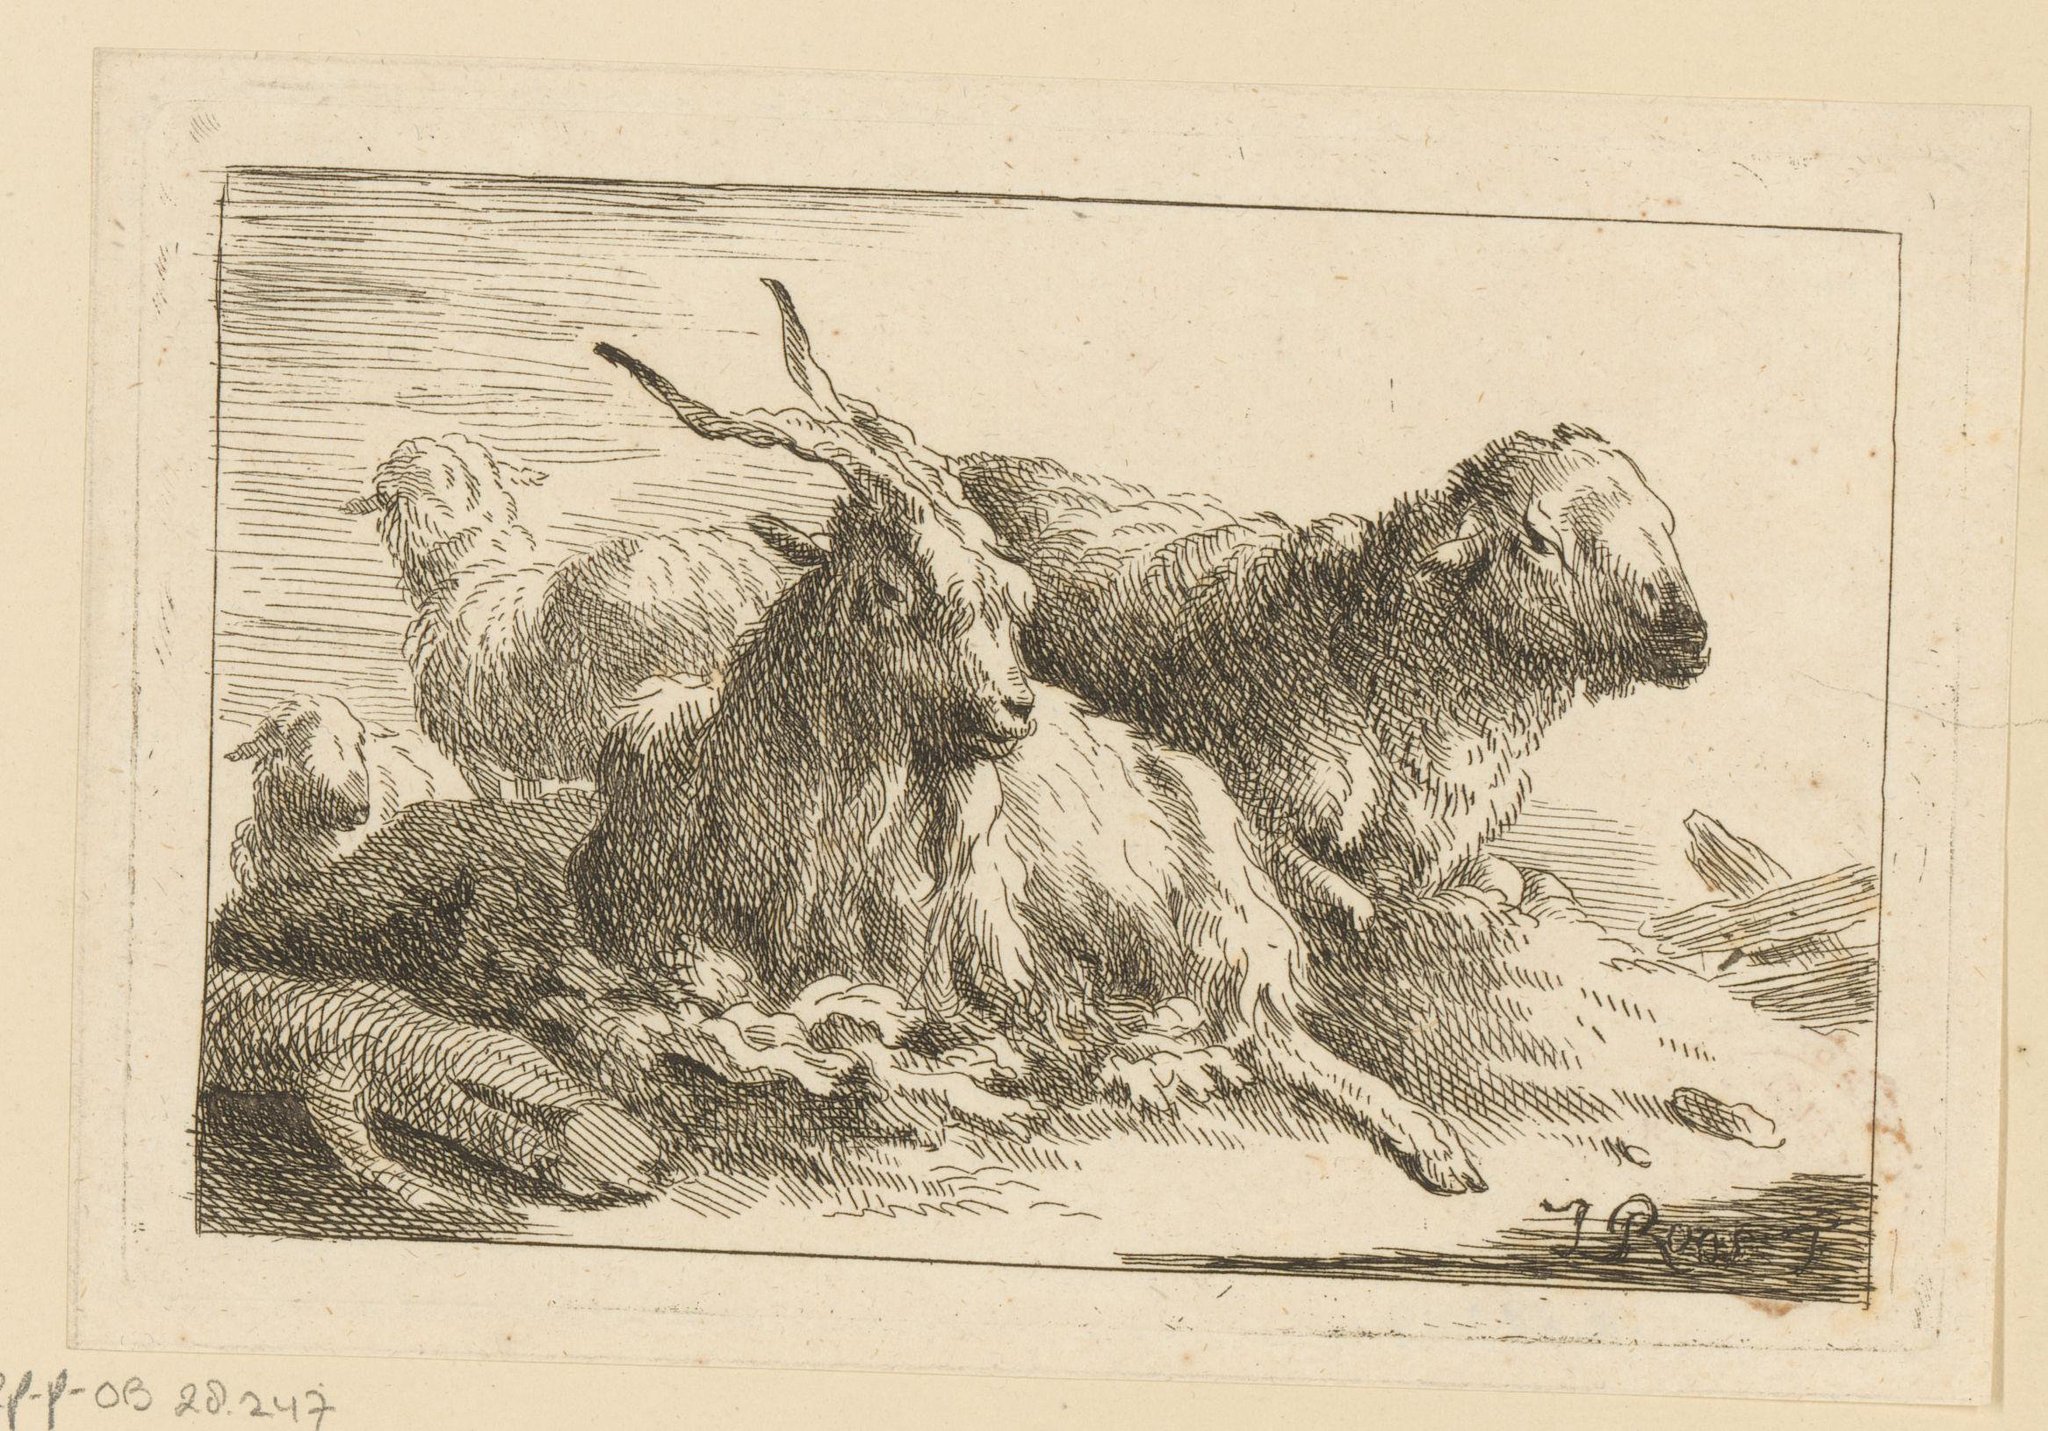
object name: print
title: Geit en drie schapen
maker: joseph roos (i)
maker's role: print maker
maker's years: 1726-1805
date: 1754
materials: paper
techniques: etching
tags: landscapes, sheep, goat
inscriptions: collector's mark: Lugt 240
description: Serie van twaalf prenten, waarvan één titelprent.